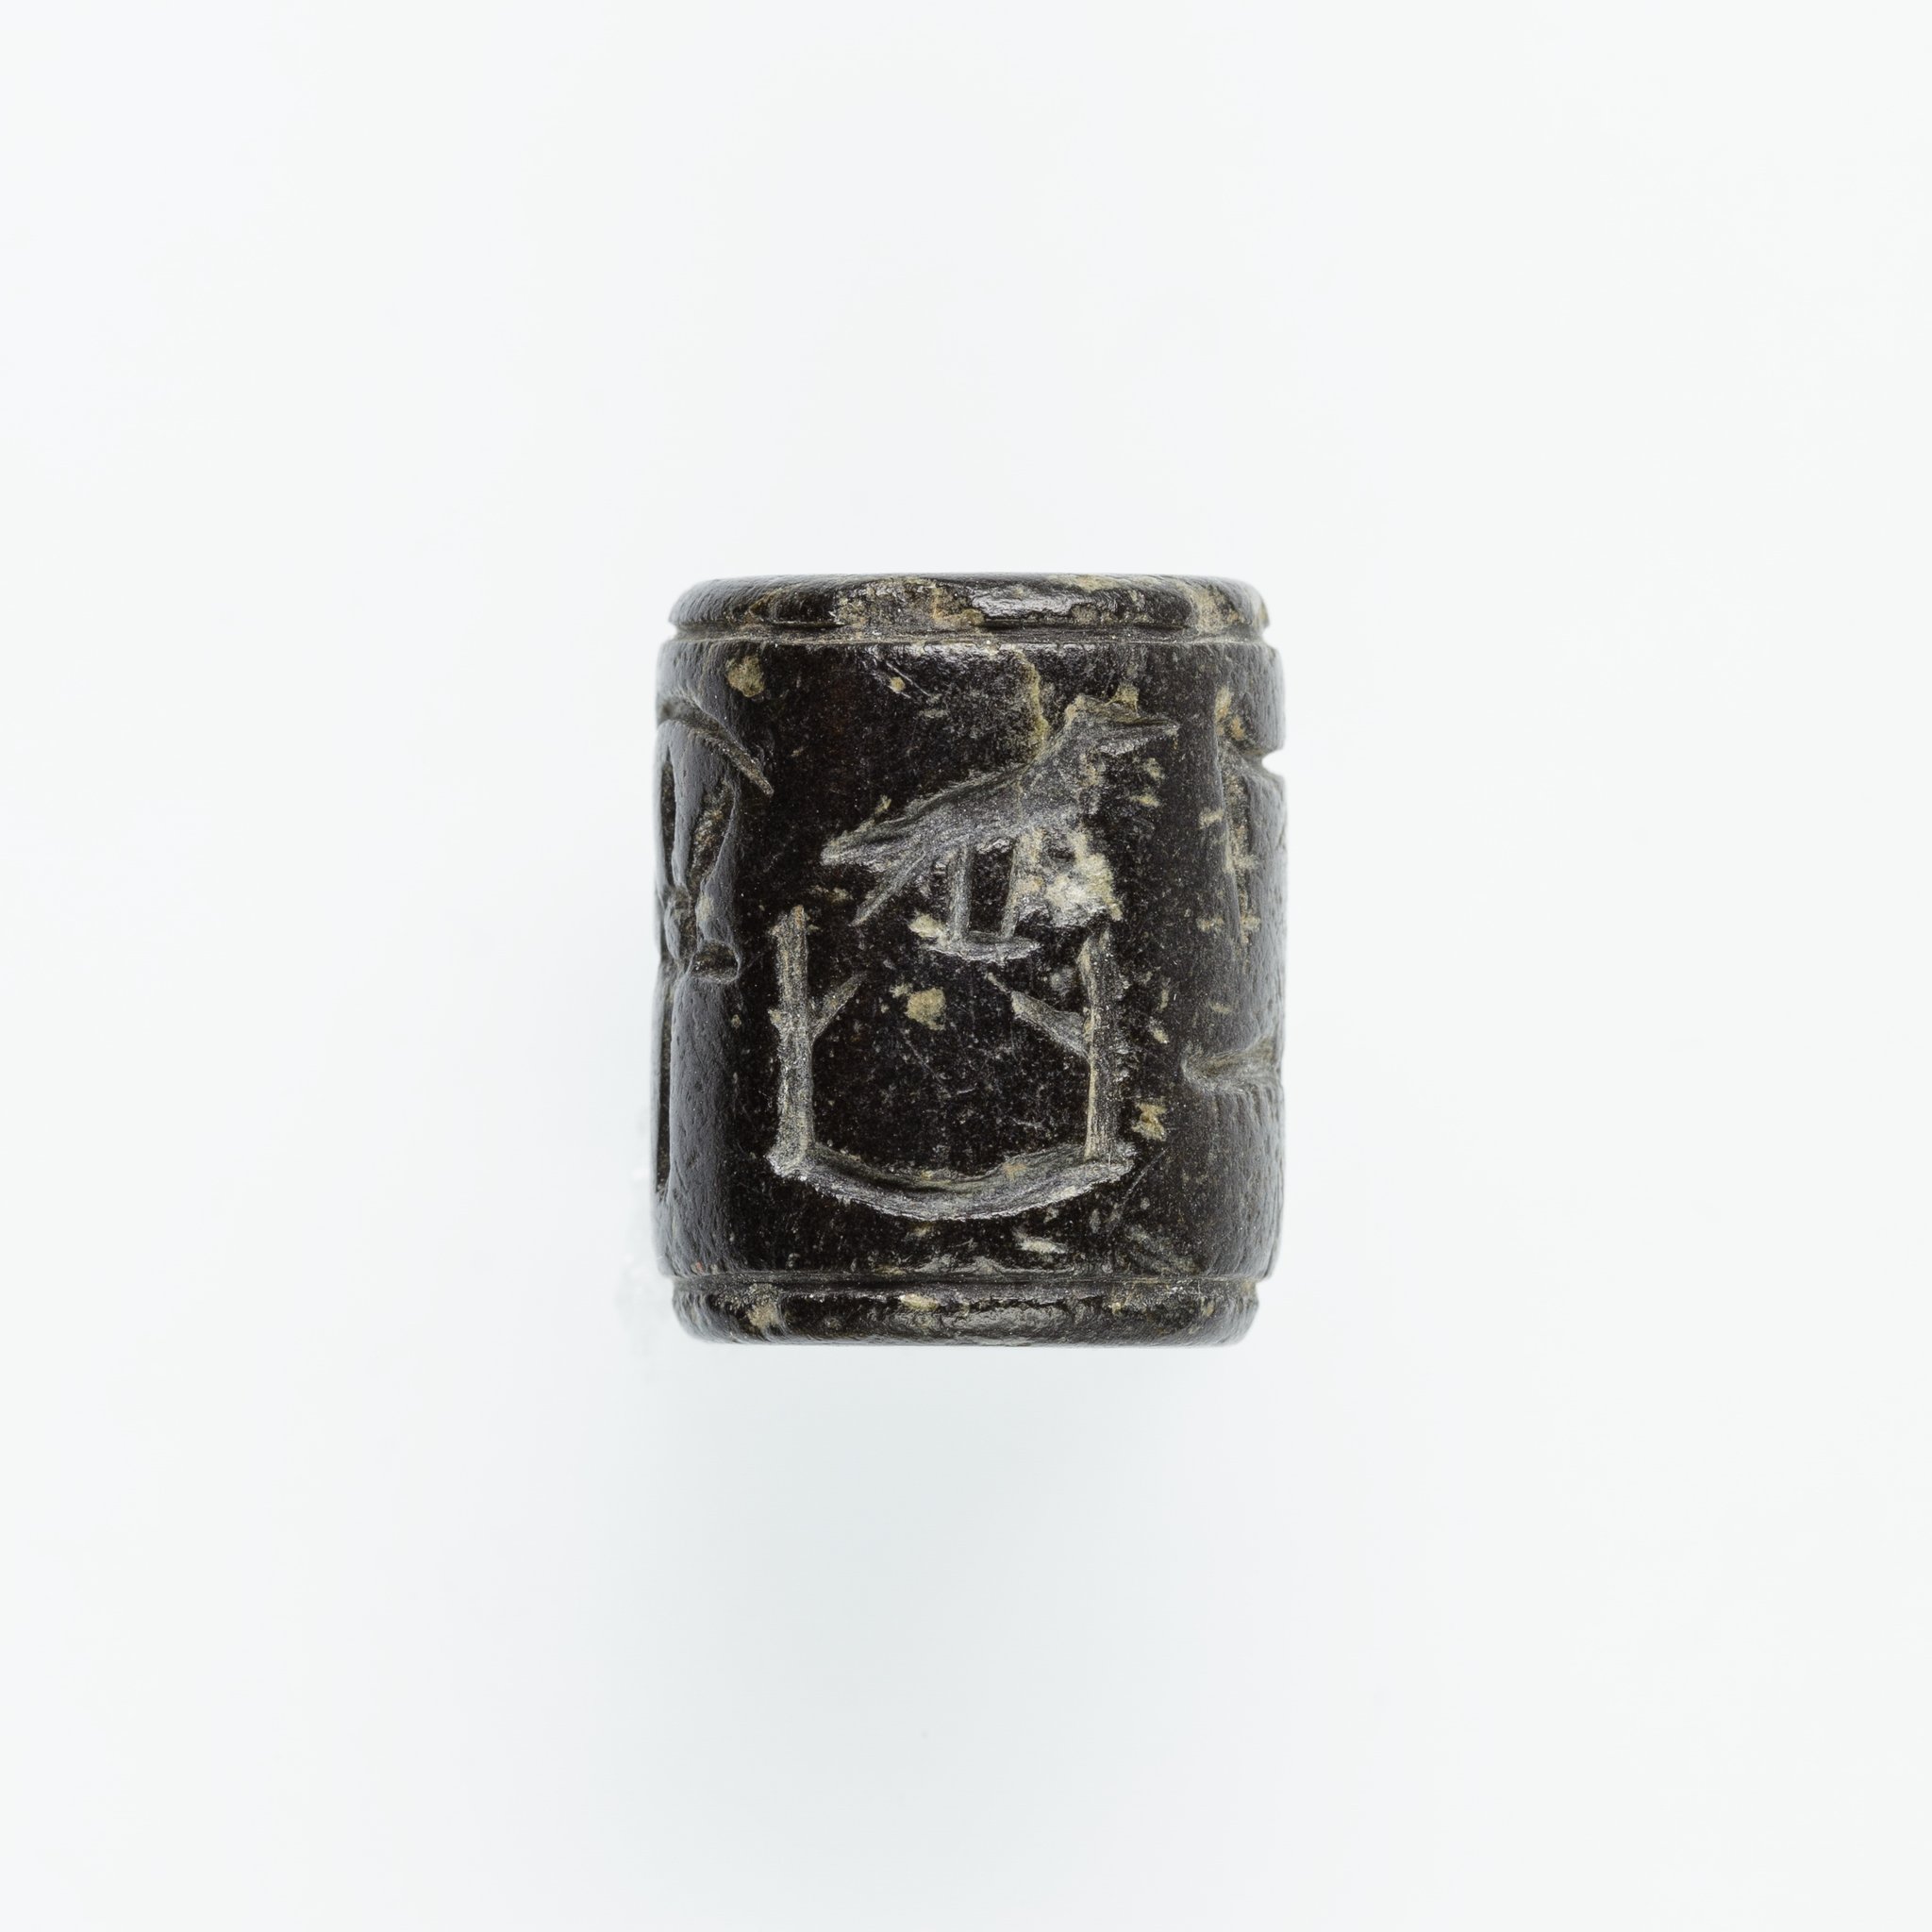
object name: cylinder seal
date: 2960-2649 BCE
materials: stone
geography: egypt